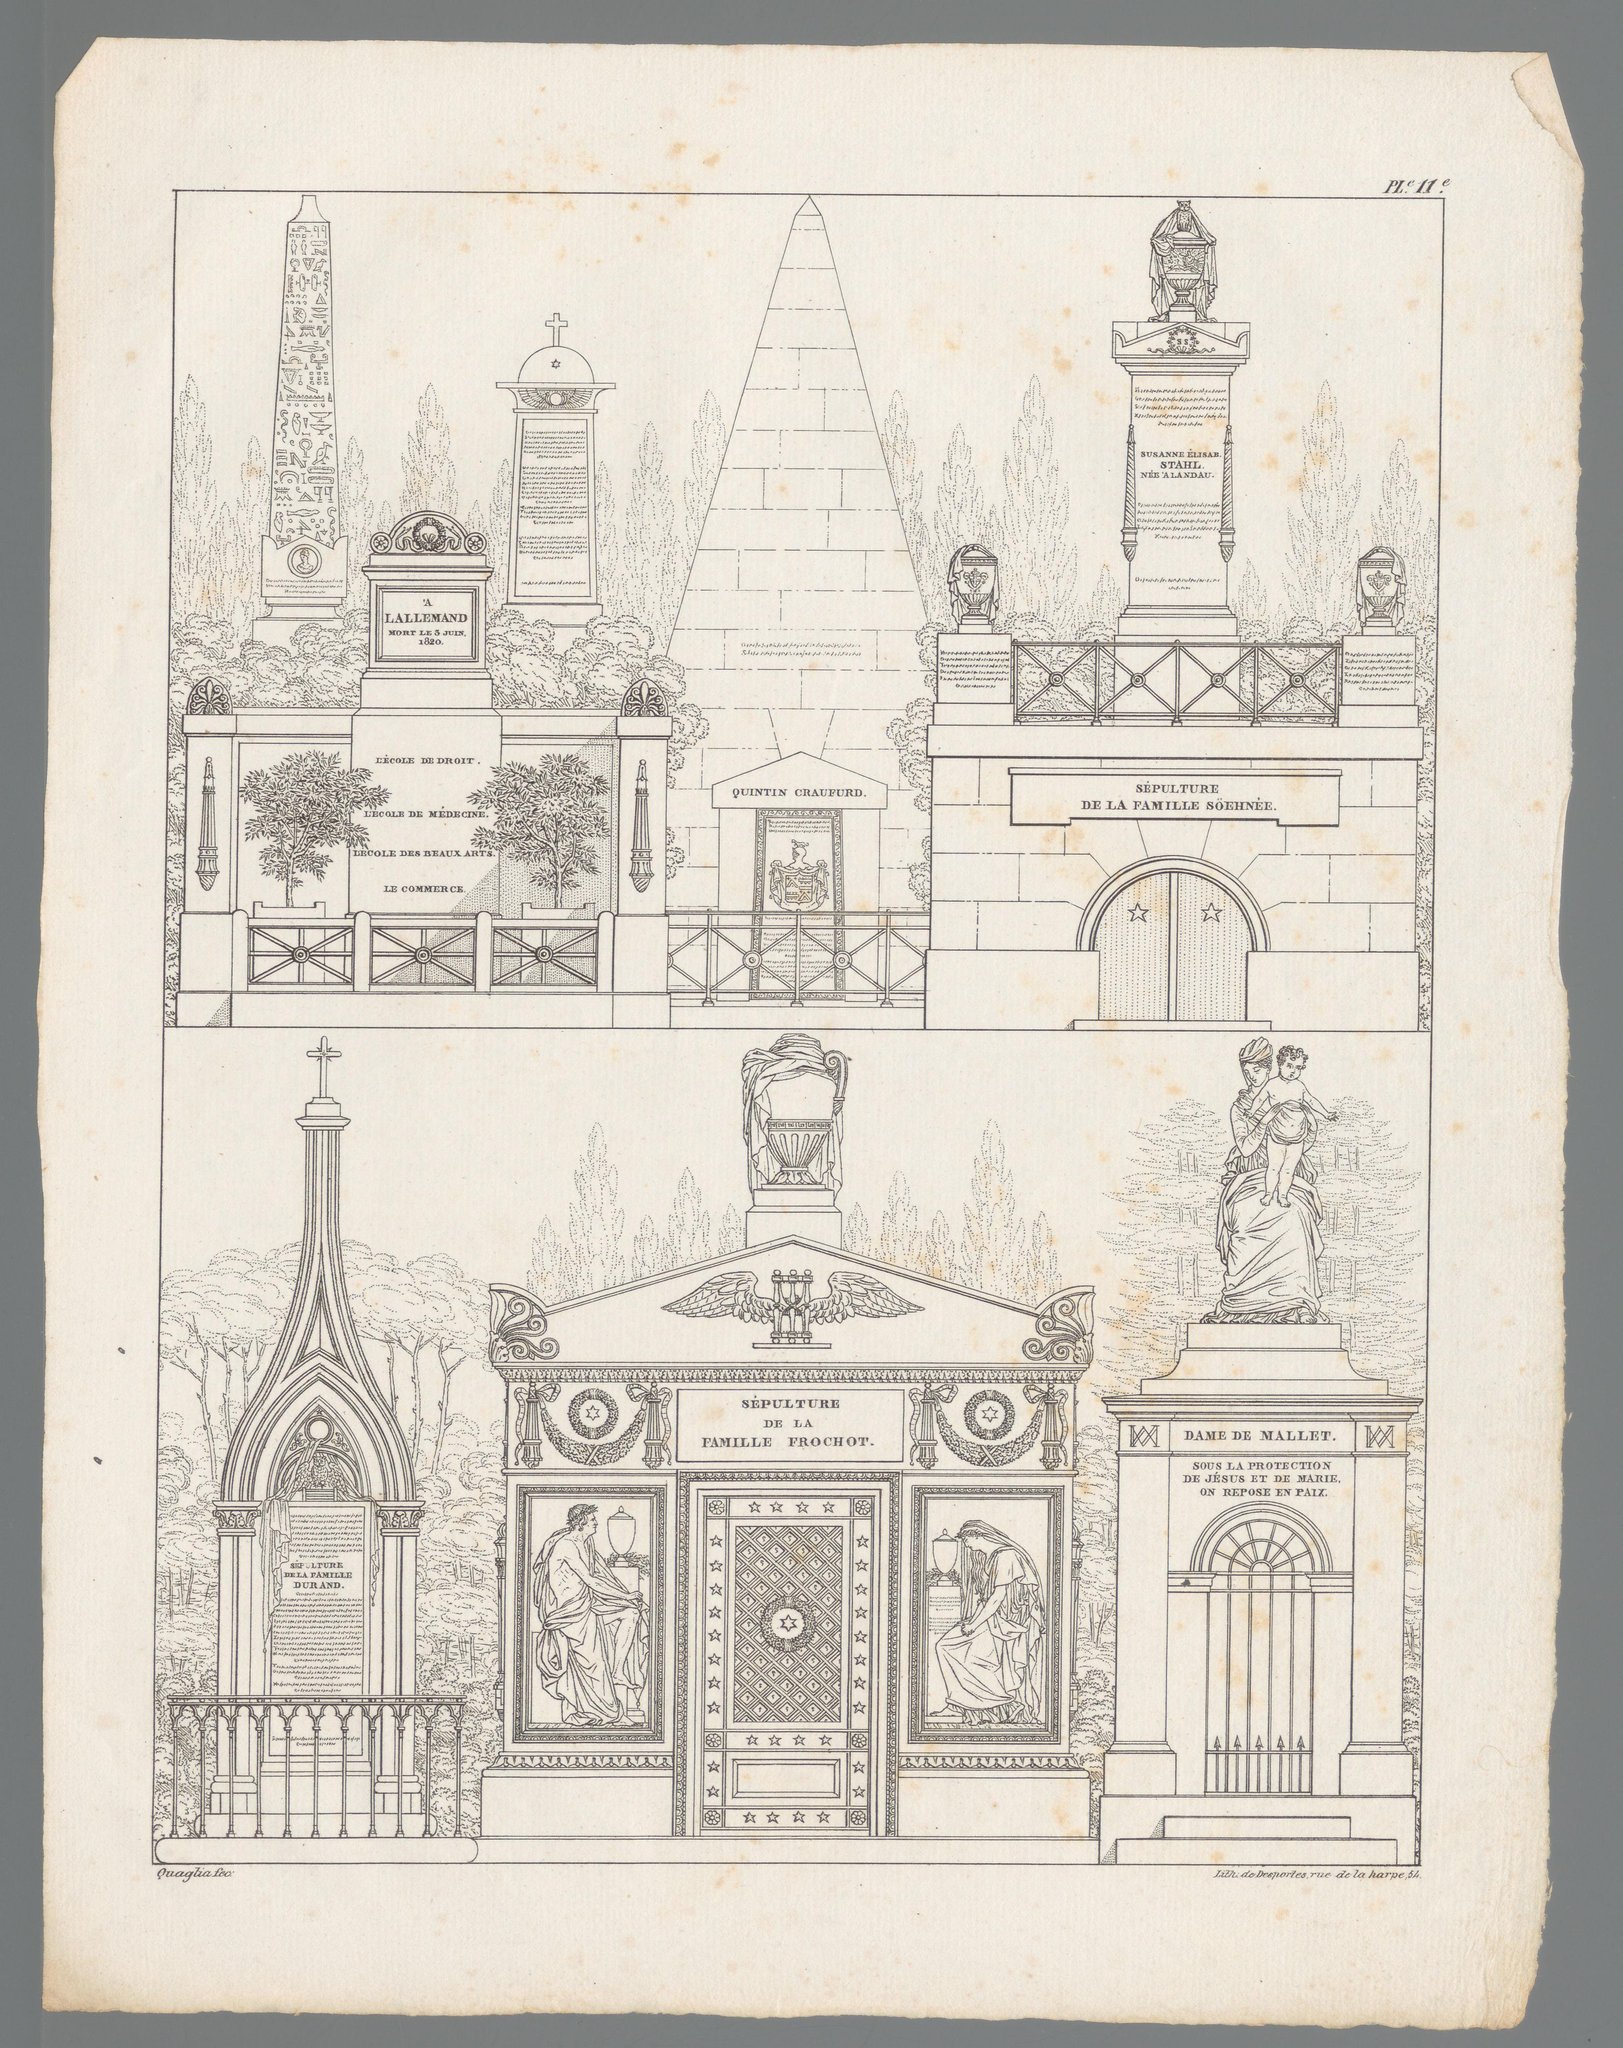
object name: print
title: Grafmonumenten op Père-Lachaise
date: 1803-1869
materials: paper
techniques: lithograph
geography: paris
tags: cemetery, park-like burying ground